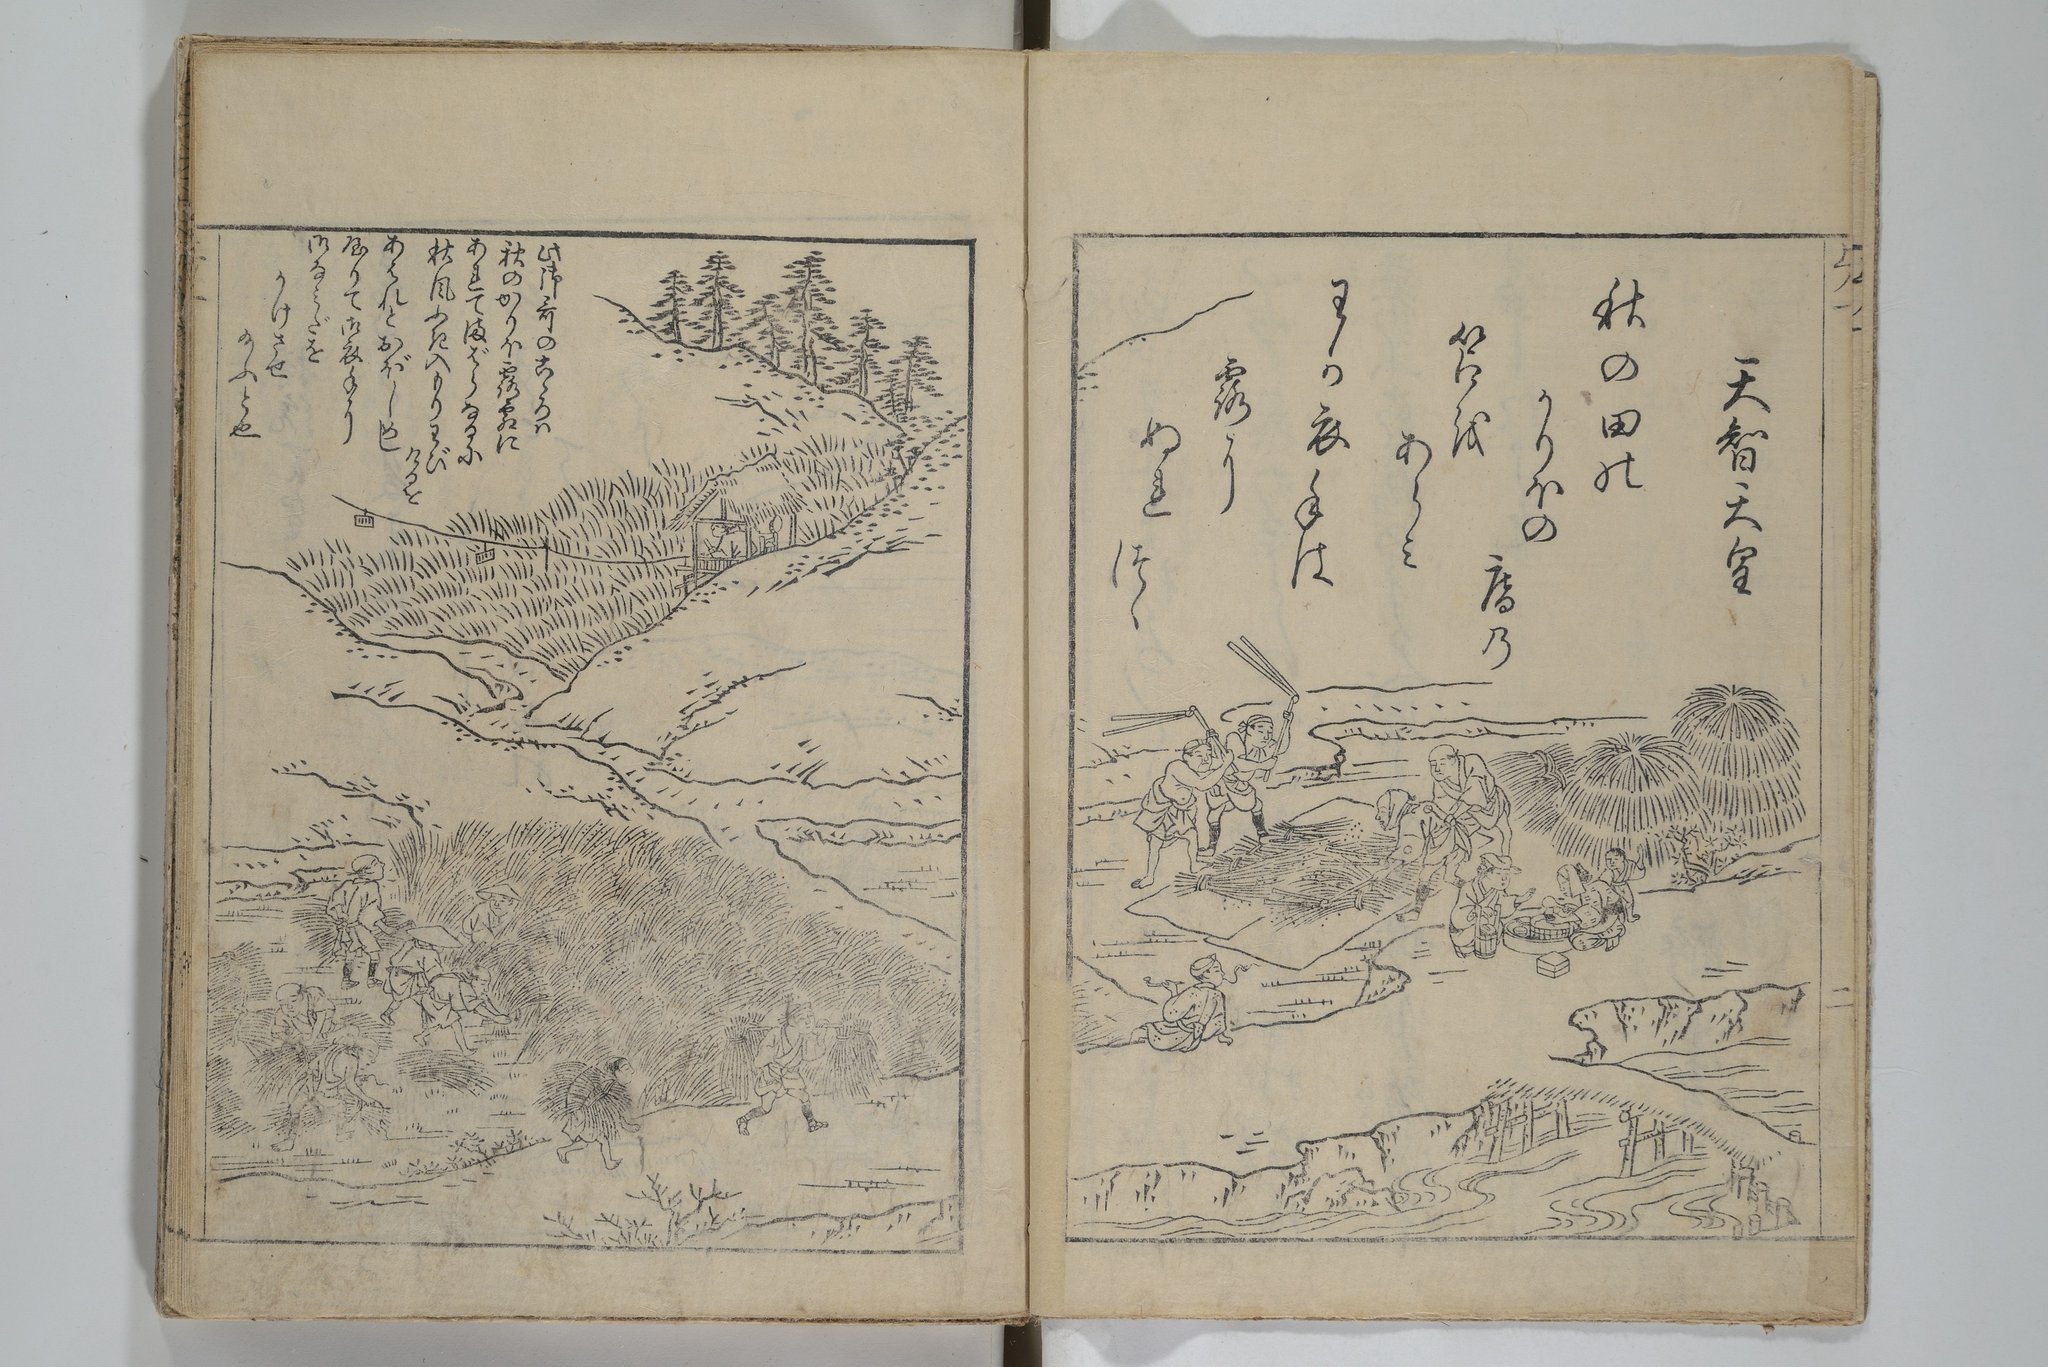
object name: illustrated book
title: Picture Book of Ogura Hill (Ehon ogurayama) 絵本小倉山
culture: japanese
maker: nishikawa sukenobu 西川祐信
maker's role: artist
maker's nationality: japanese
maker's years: 1671-1750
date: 1749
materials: ink, paper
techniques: bookbinding, woodblock print